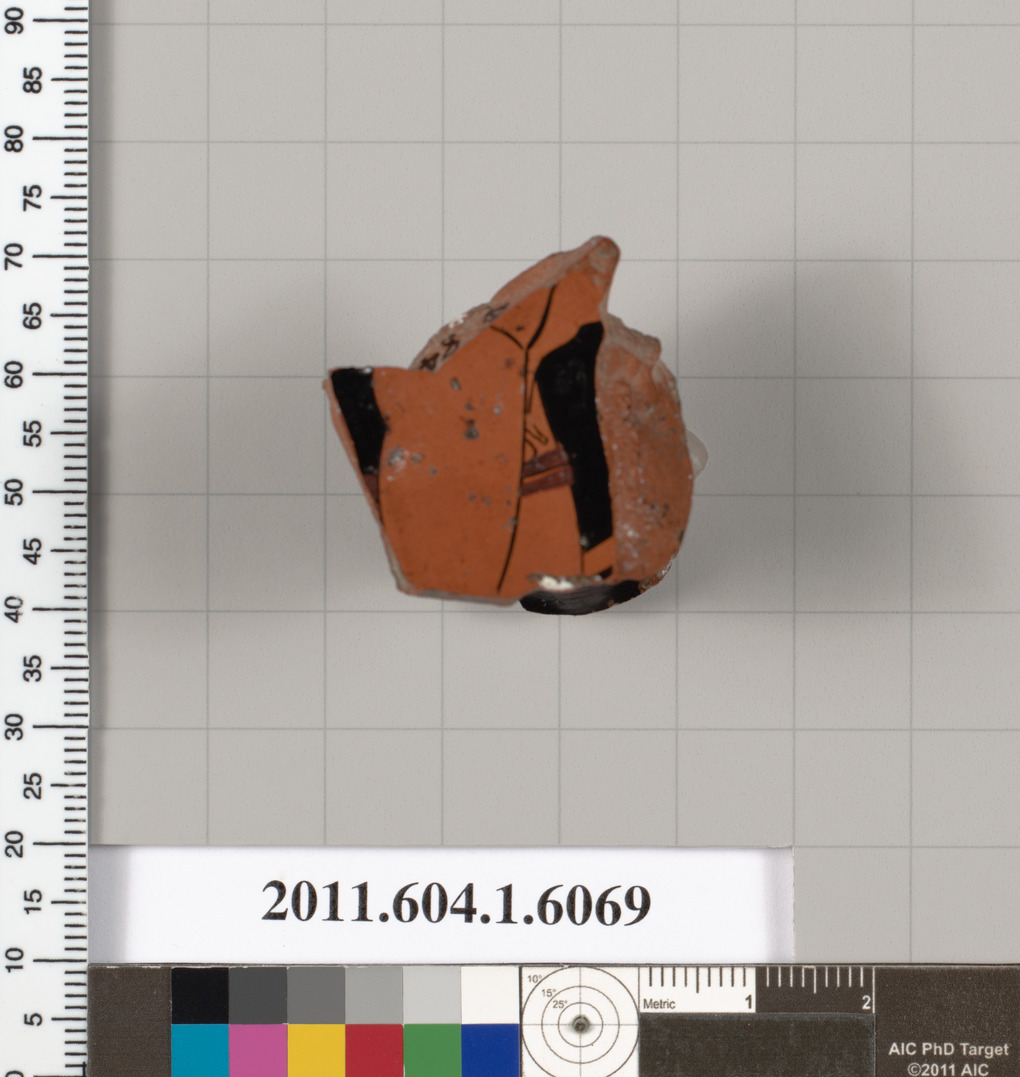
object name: kylix fragment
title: Terracotta fragment of a kylix (drinking cup)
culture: greek, attic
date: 510-500 BCE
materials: terracotta